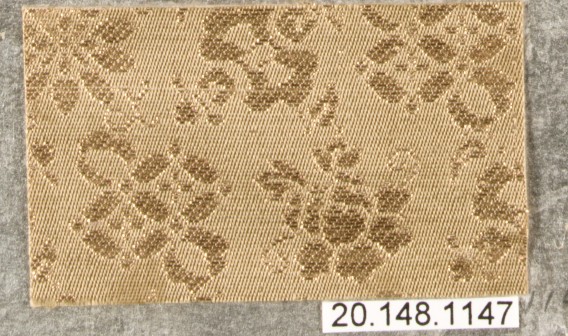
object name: piece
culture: japanese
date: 1801-1900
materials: silk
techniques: compound weave